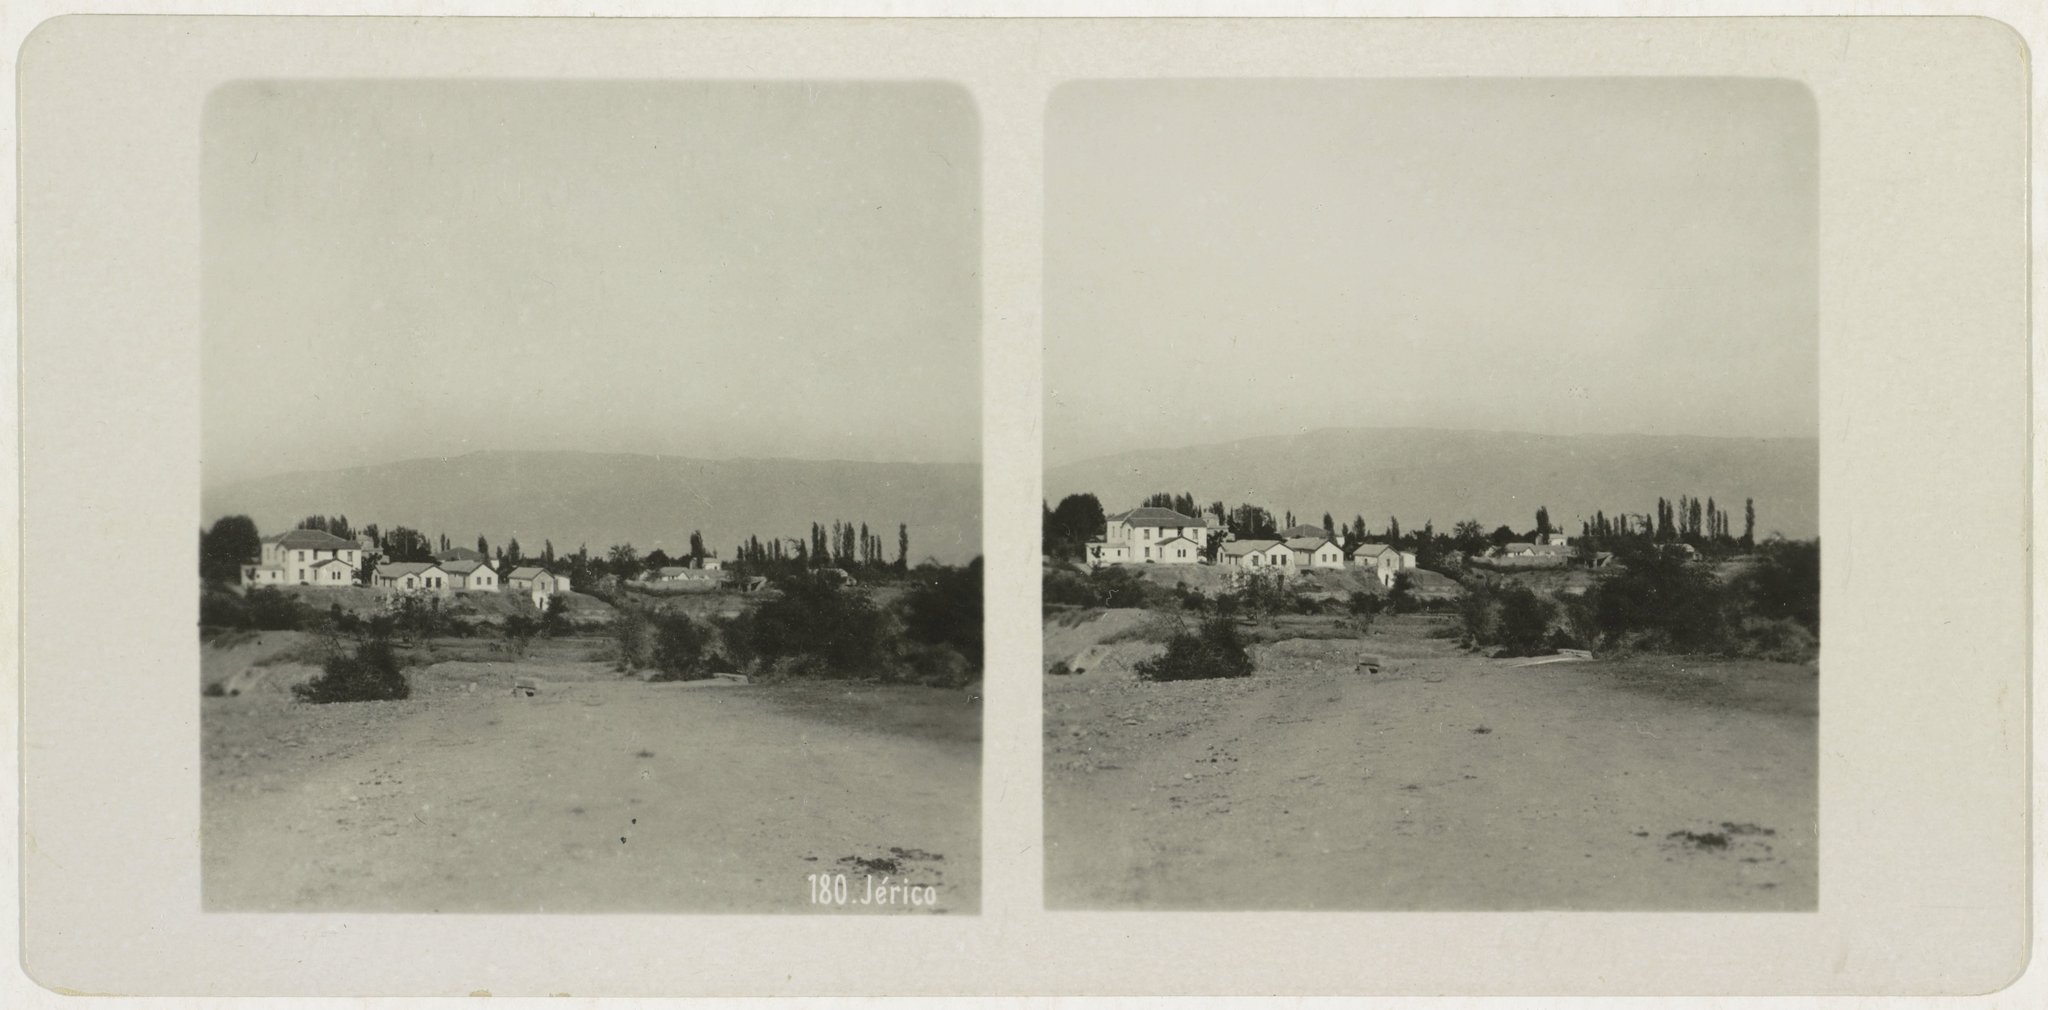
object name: stereograph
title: Jérico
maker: richard sochor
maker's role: painter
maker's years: 1867-1925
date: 1903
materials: paper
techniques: gelatin silver print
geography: jericho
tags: city-view in general; 'veduta'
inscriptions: address: ‘Parklaan 49/ HAARLEM/ (Holland)’, inscription: ‘Déposée.’, monogram, inscription: ‘Deze stereo-foto's worden in den handel gebracht en en gros en/ en détail verkocht door de ......... (...)’, number: ‘180.’